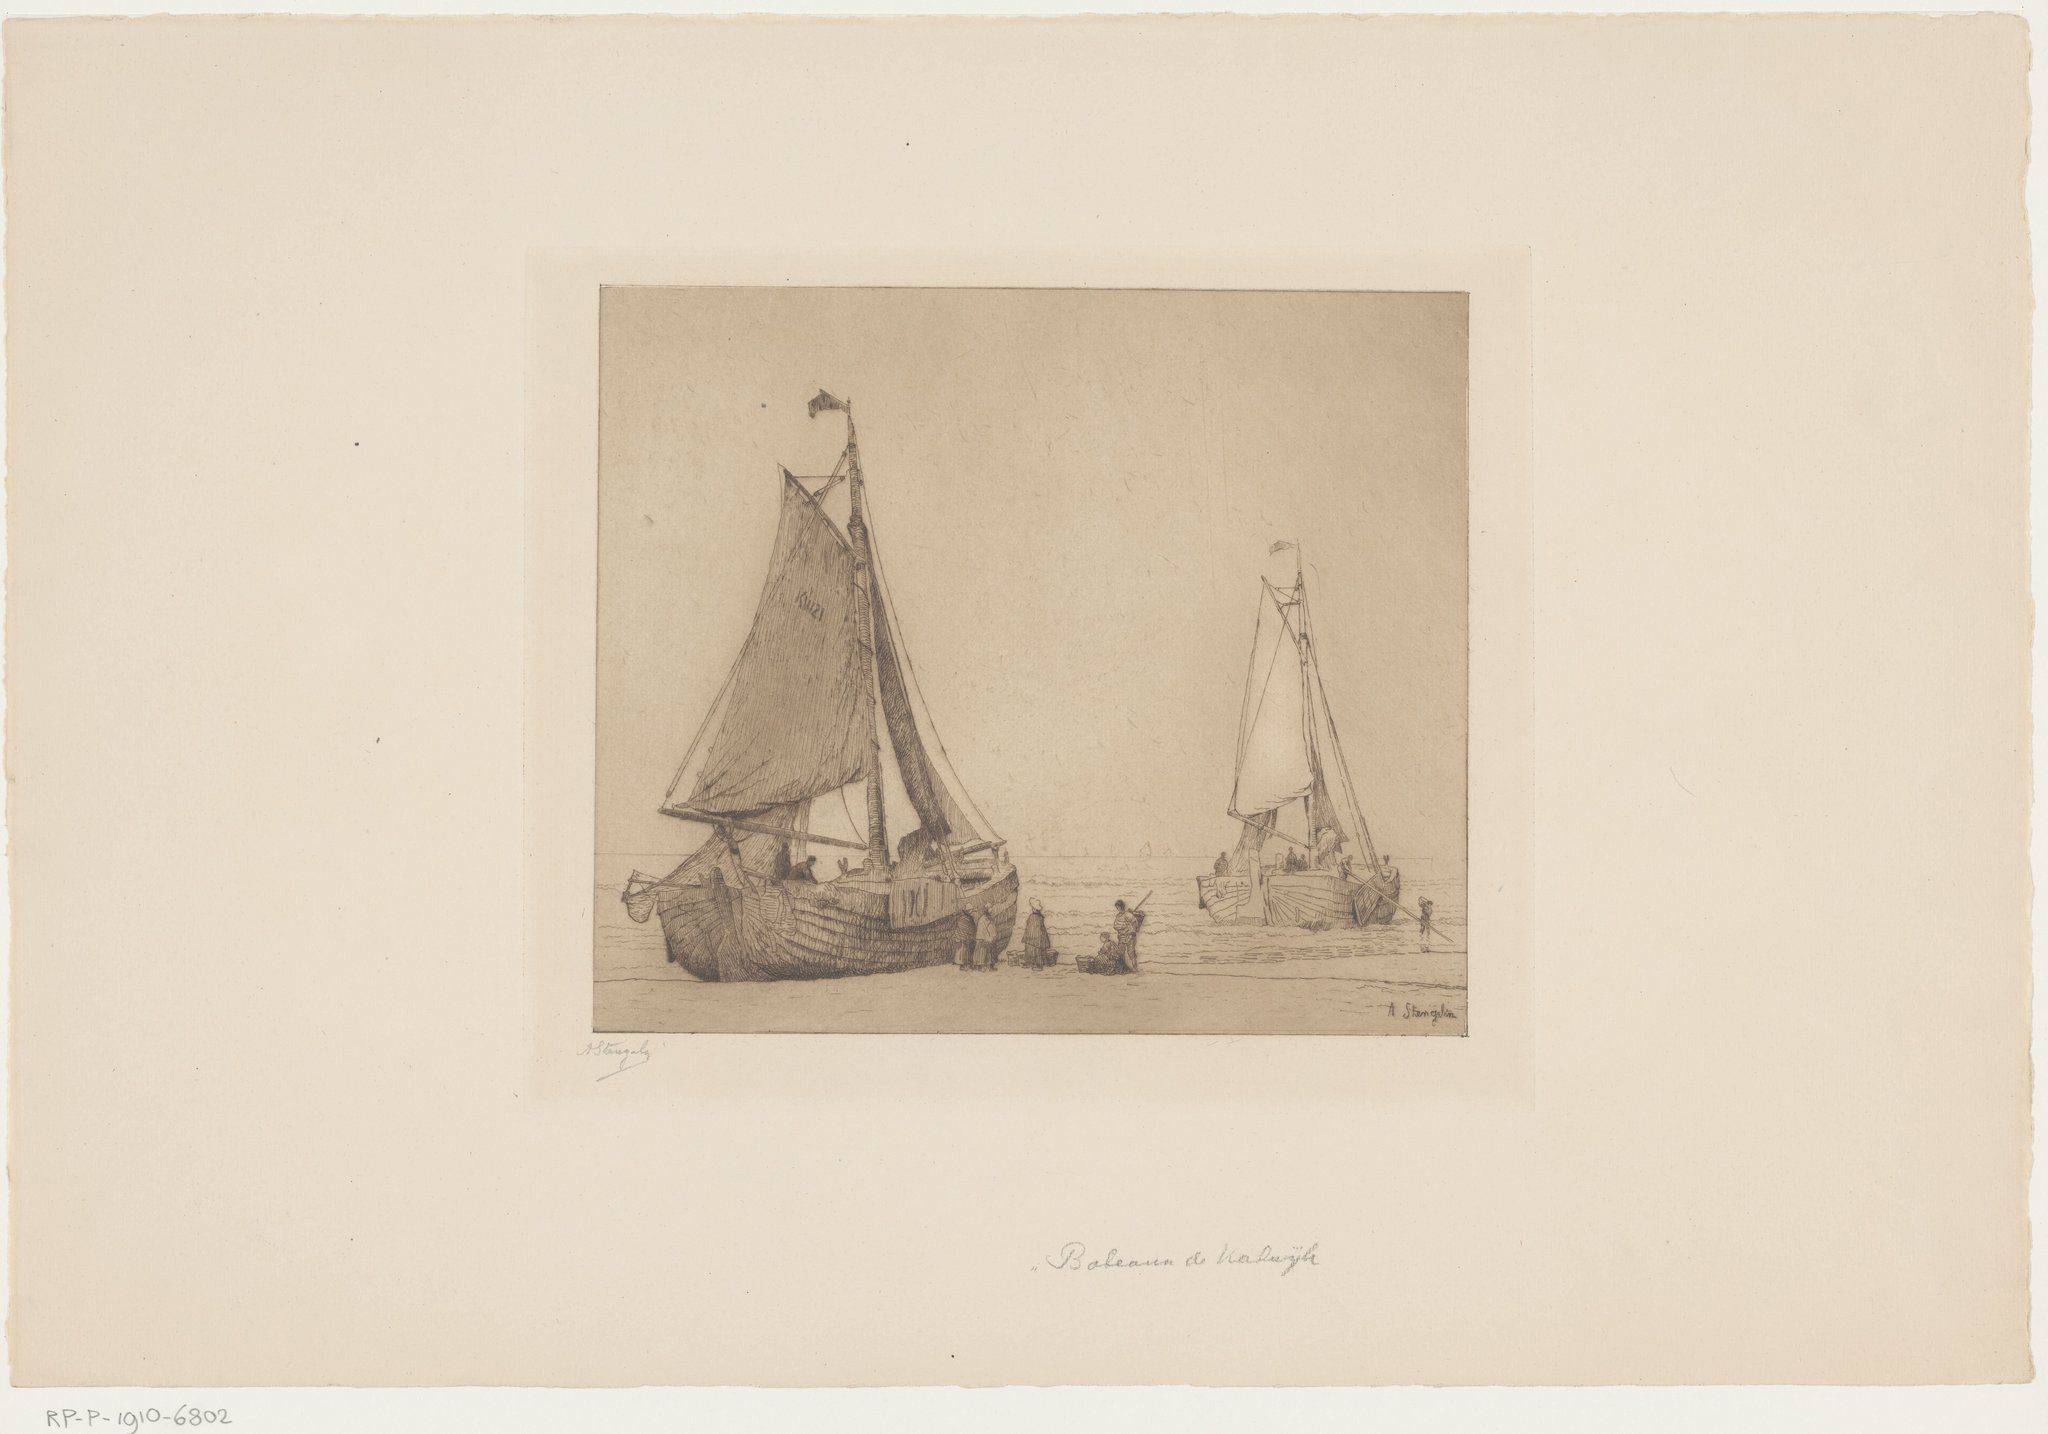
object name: print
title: Vissersboten te Katwijk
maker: alphonse stengelin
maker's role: painter, print maker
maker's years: 1852-1938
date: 1862-1910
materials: paper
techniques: etching, intaglio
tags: sailing-ship, sailing-boat, beach, sea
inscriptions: collector's mark: Lugt 2228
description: Twee boten op het strand van Katwijk, waarvan één op het land ligt en de ander in het water.